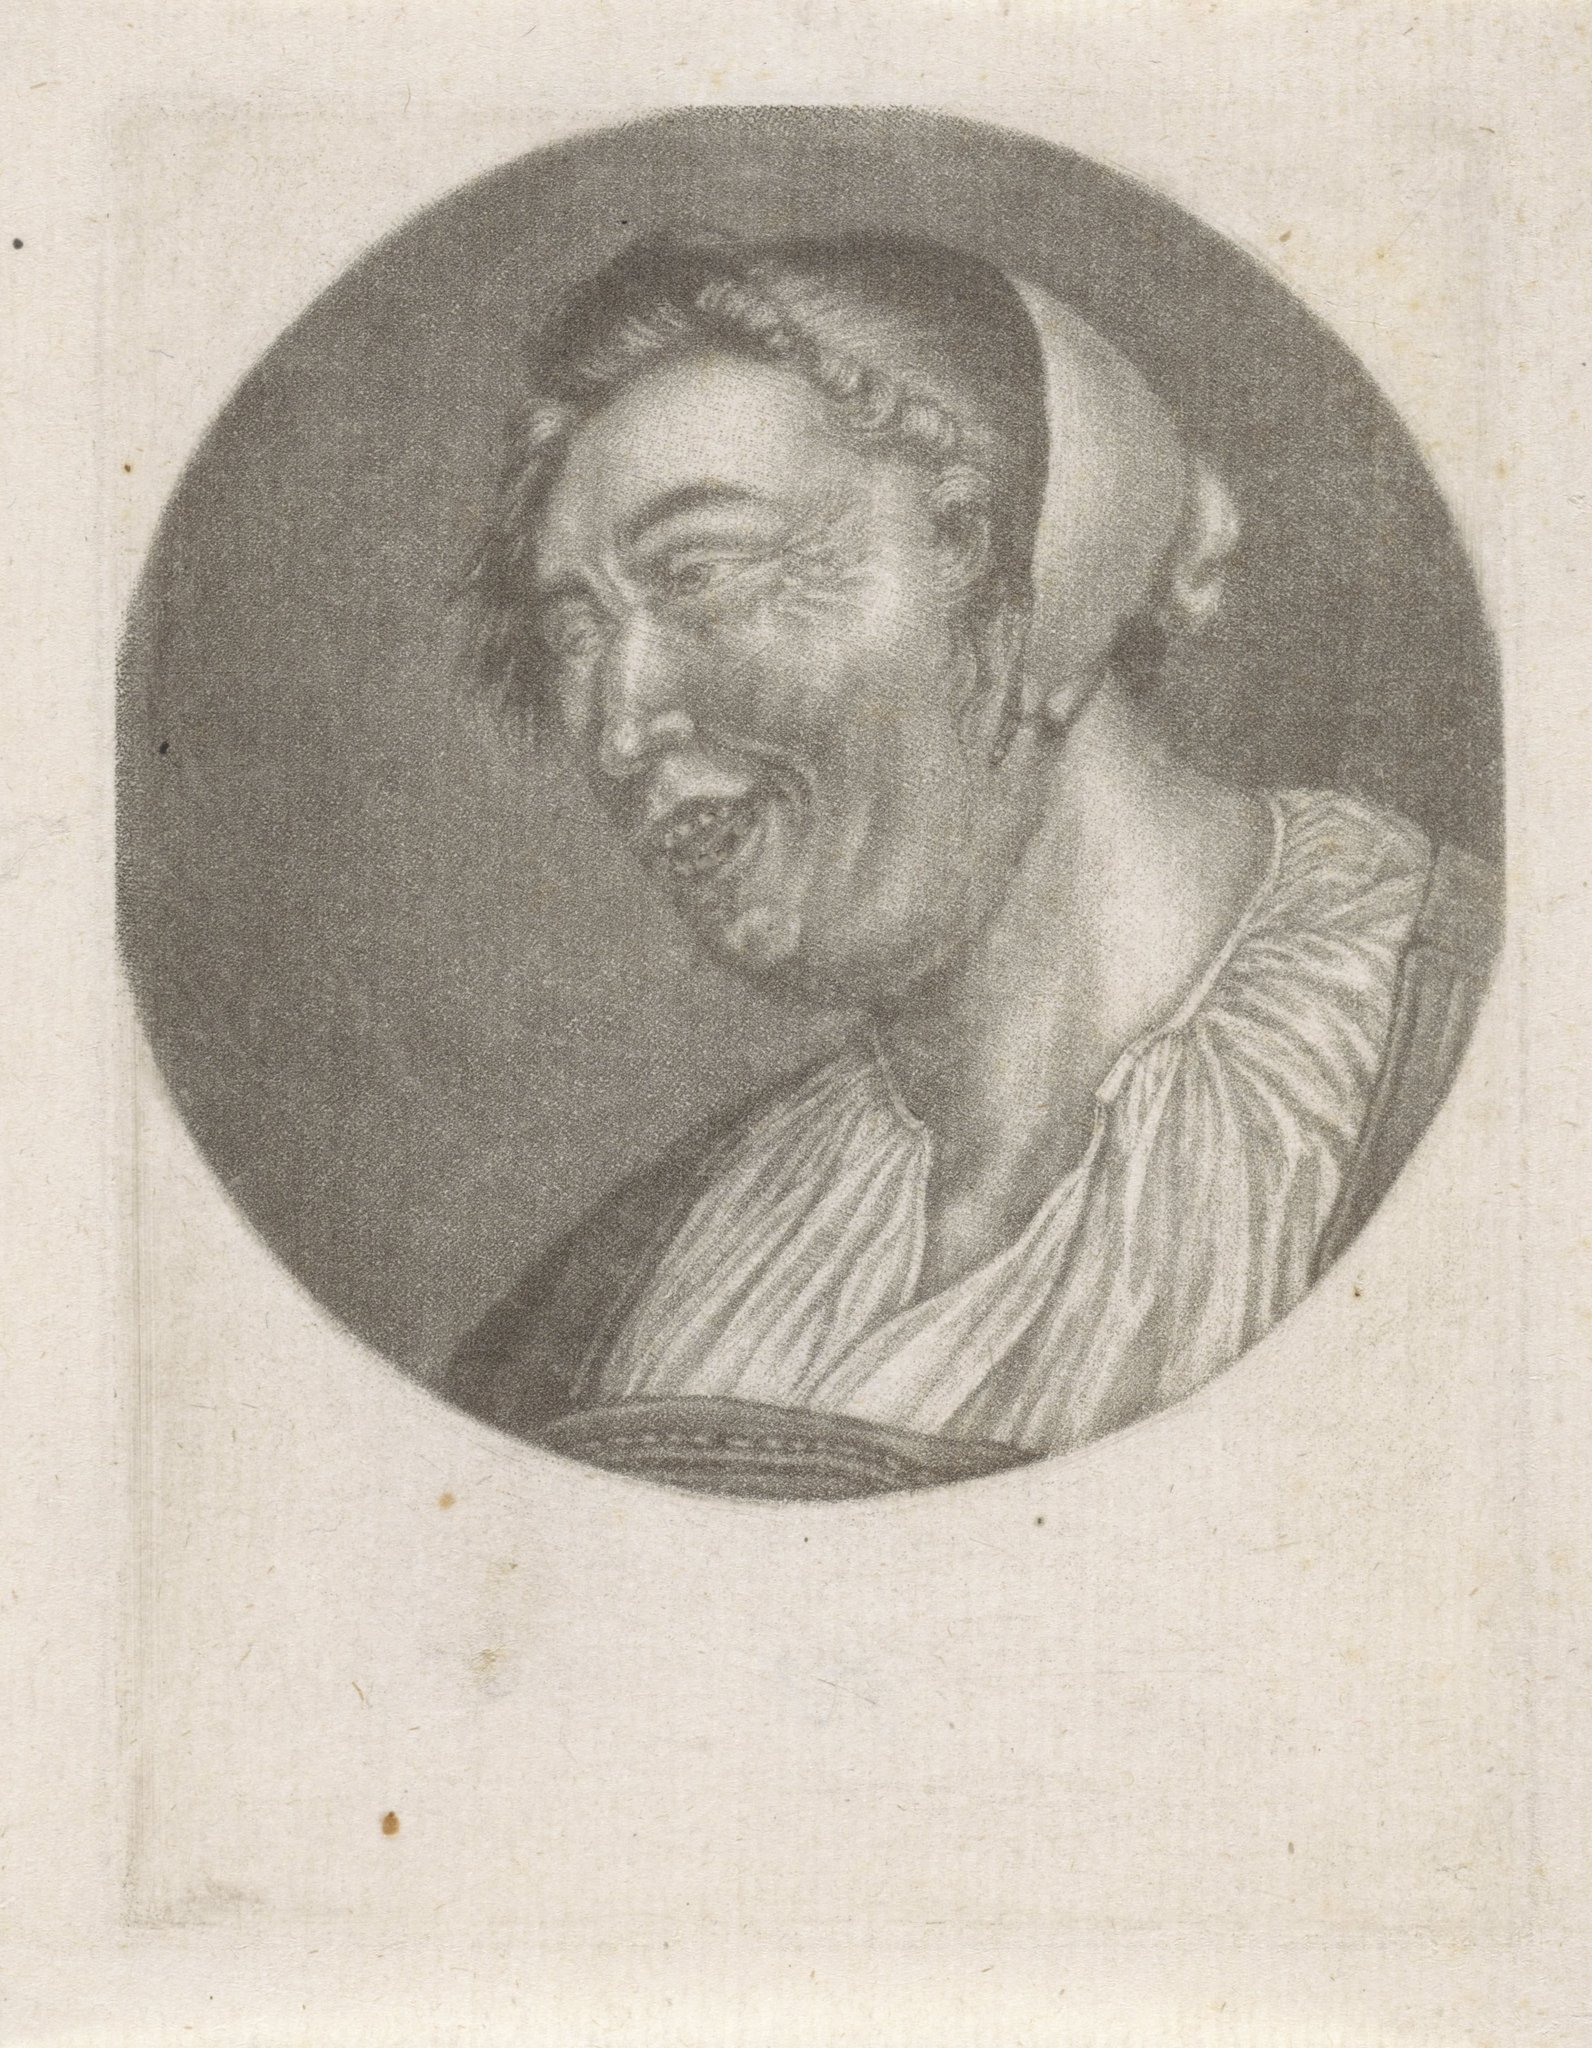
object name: print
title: Mannen- en vrouwenkoppen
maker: Anonymous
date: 1650-1800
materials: paper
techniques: mezzotint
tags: laughing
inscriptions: collector's mark: Lugt 2228